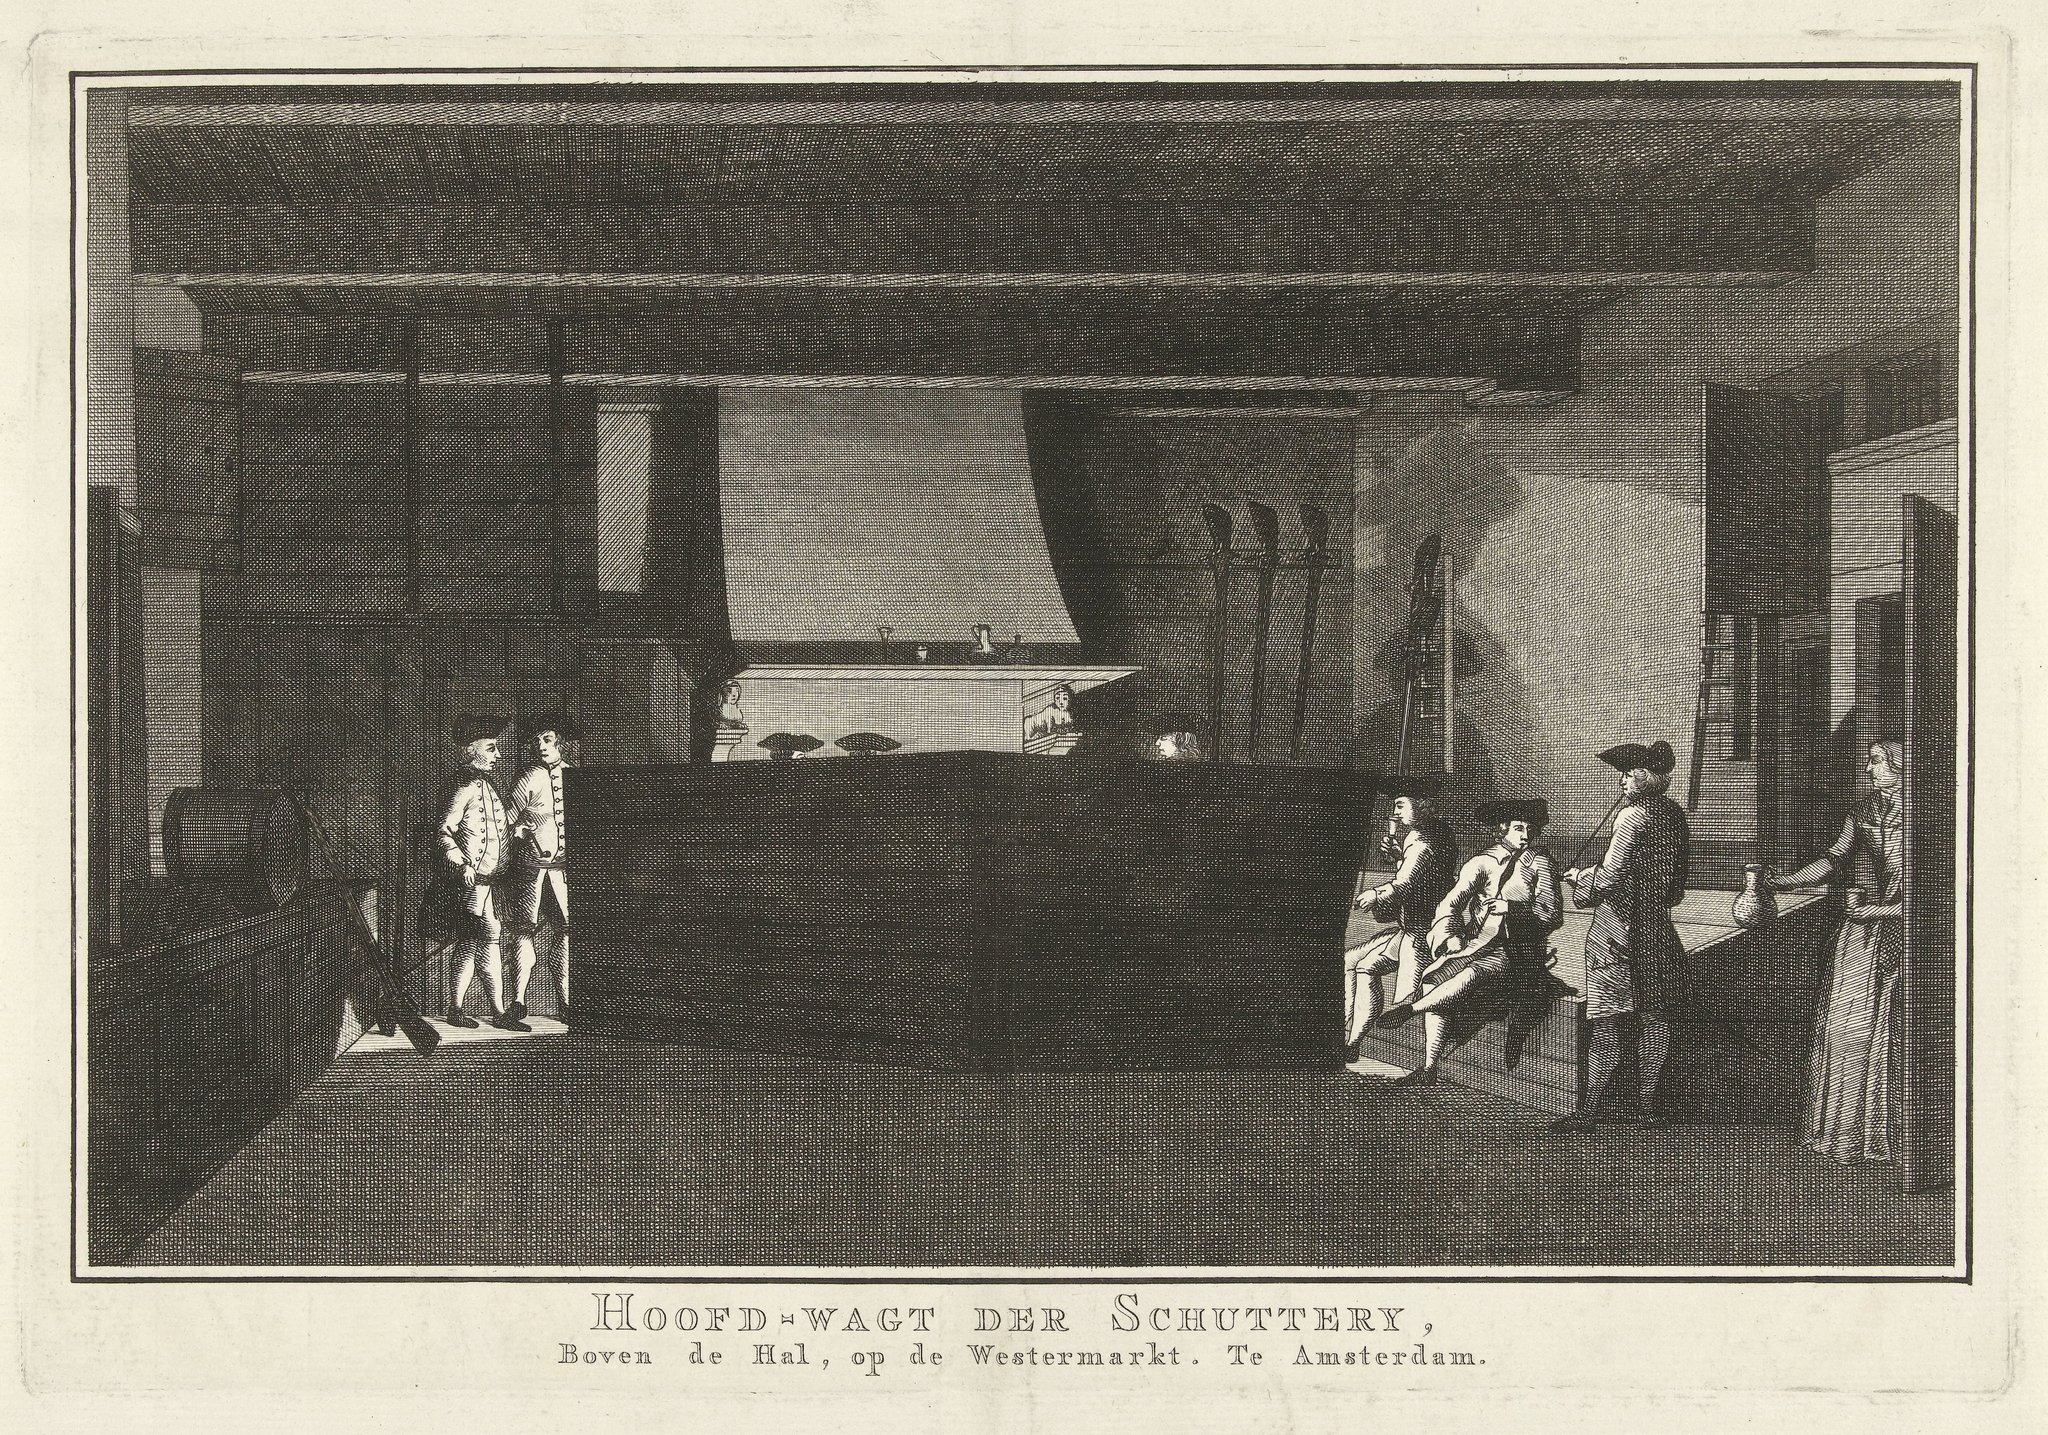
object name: print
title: Hoofd-wagt der Schuttery, Boven de Hal, op de Westermarkt. Te Amsterdam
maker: hendrik van hilten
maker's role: draughtsman, print maker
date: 1750-1793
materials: paper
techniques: etching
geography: northern netherlands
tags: pipe ~ tobacco, guard duty, keeping sentry, night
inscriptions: collector's mark: Lugt 2228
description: Gezicht op het interieur van de hoofdwacht van de schutterij op de Westermarkt te Amsterdam bij nacht, met enkele figuren bij kaarslicht.